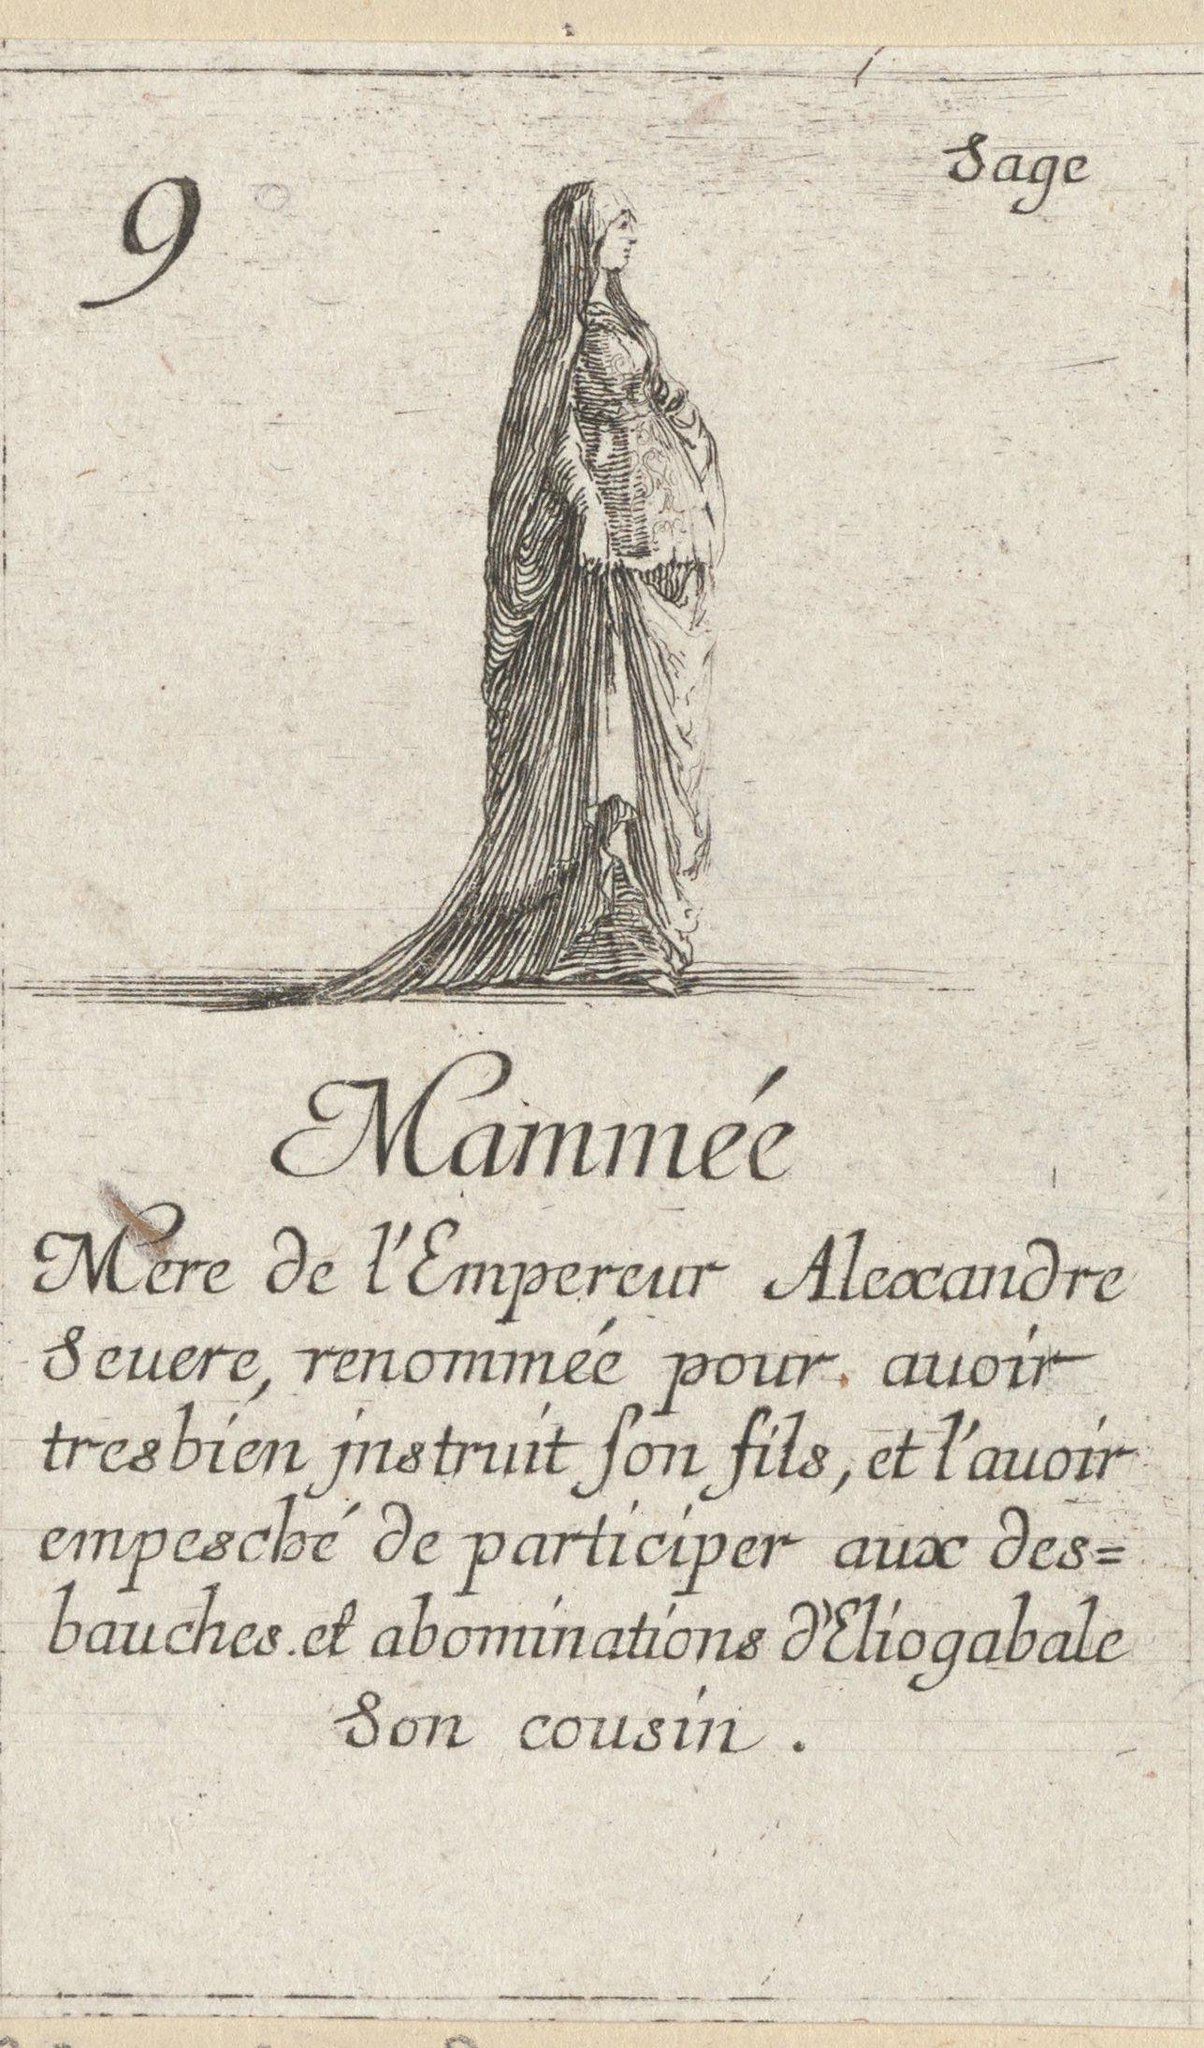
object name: playing card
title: Kaartspel met gerenommeerde heerseressen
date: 1620-1664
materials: paper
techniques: etching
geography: paris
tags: ruler, sovereign - bb - female ruler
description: Deze prent maakt deel uit van een kaartspel met 52 kaarten met voorstellingen van beroemde koninginnen. De serie is uitgedacht door Jean Desmarests de Saint-Sorlin in opdracht van Kardinaal Mazarin. Het kaartspel werd gemaakt voor de jonge Lodewijk XIV, samen met het Jeu des Fables, Jeu de la Géographie en Jeu des Rois de France.